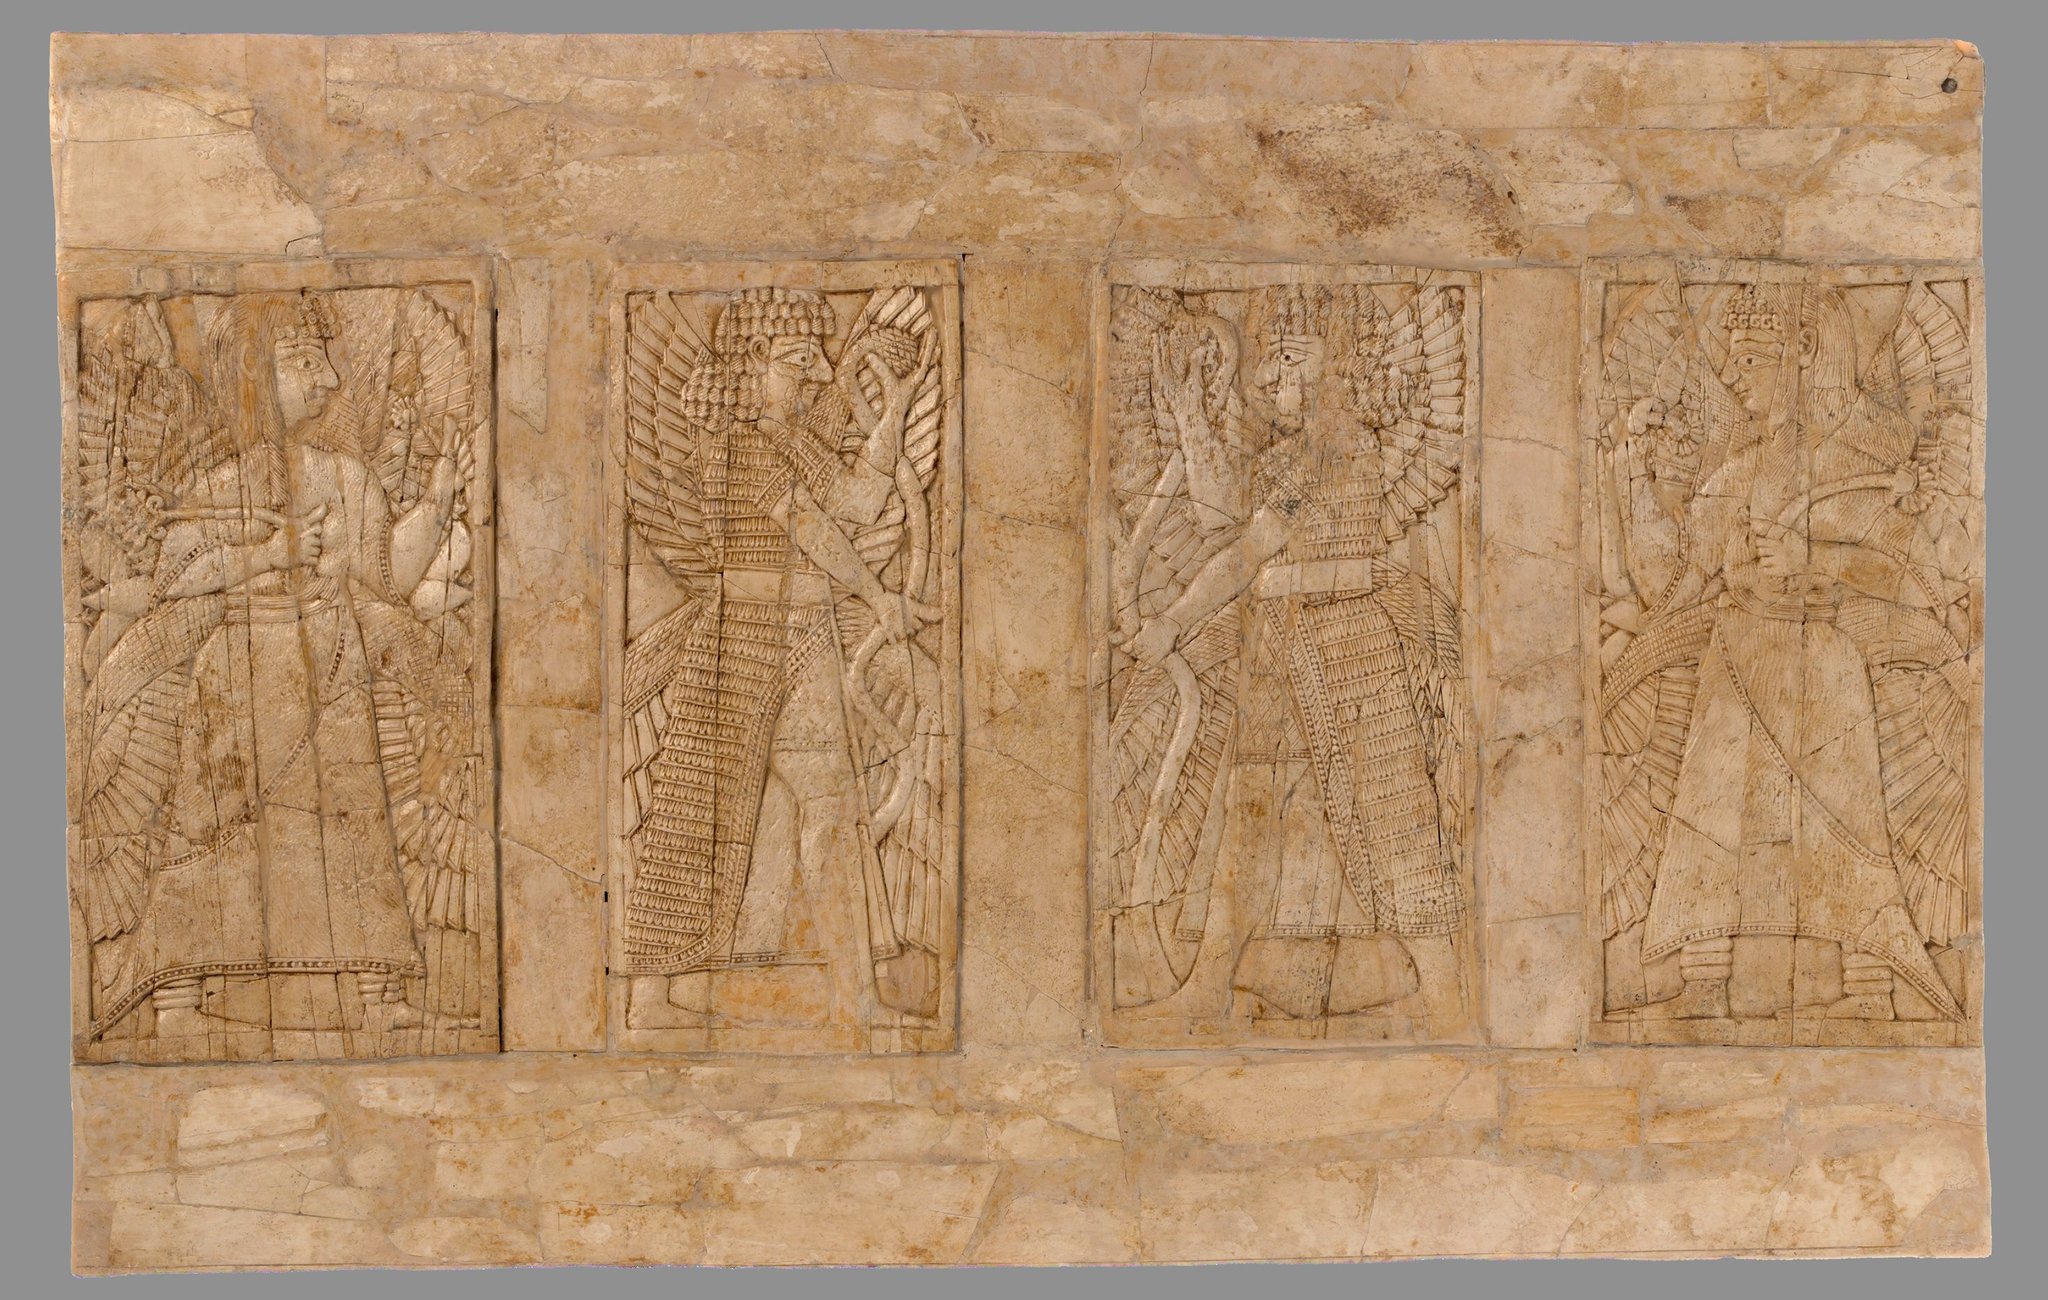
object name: chair back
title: Chair back carved in relief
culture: assyrian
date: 800-701 BCE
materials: ivory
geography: mesopotamia